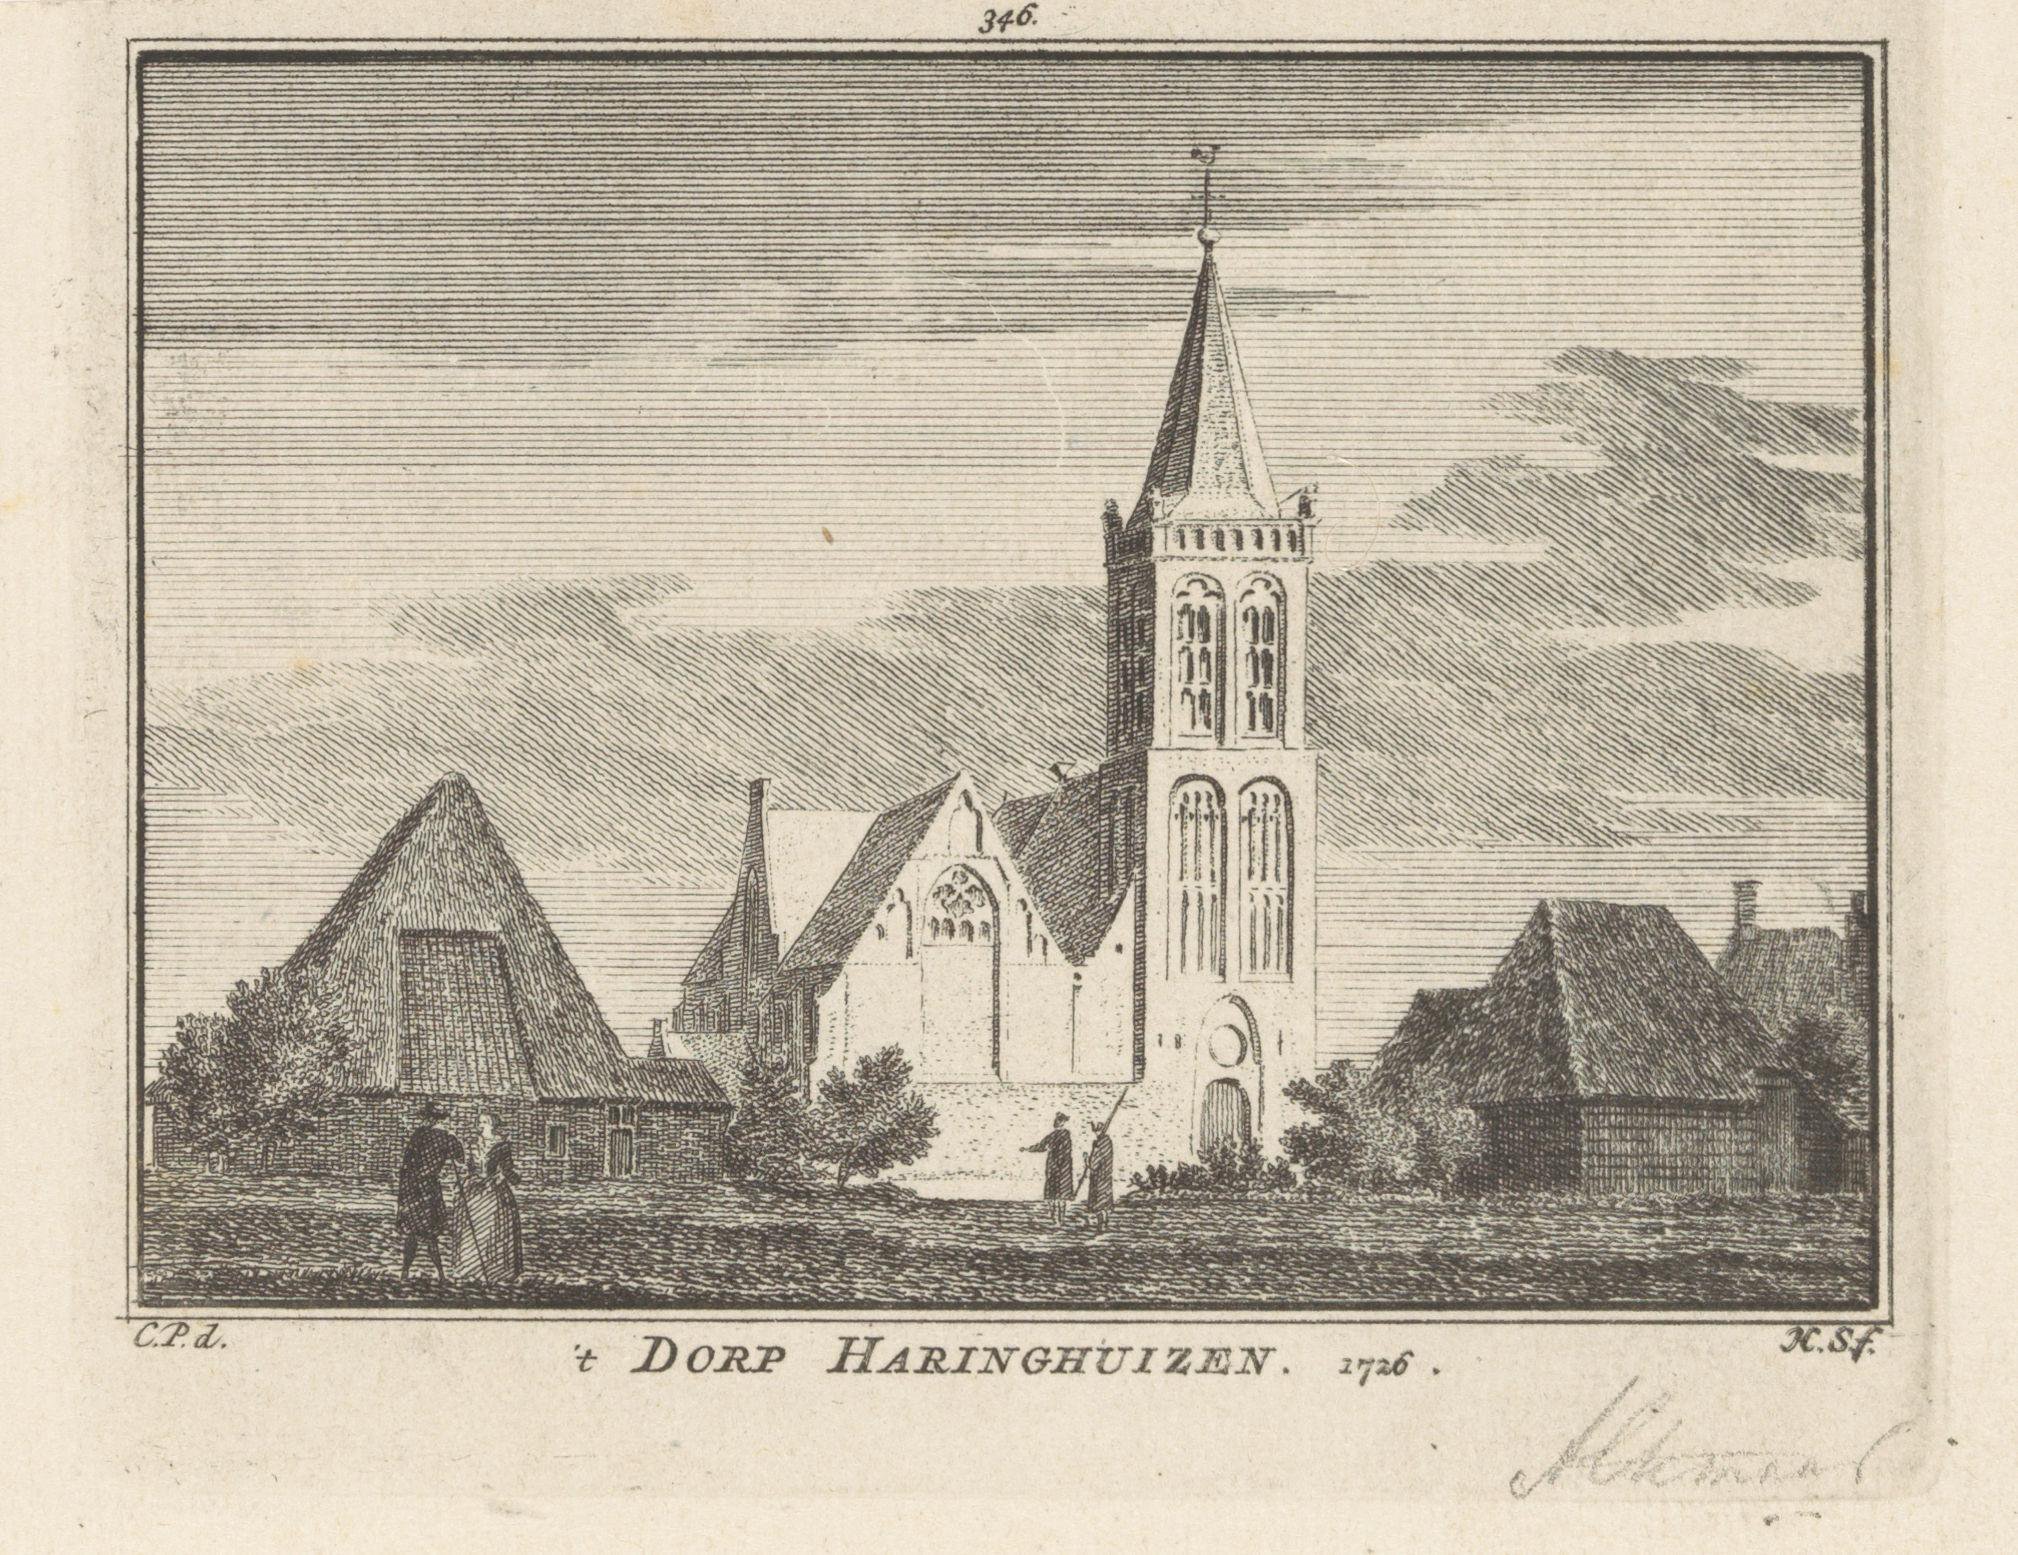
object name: book illustration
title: 't Dorp Haringhuizen. 1726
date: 1752-1792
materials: paper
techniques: engraving, etching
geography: haarlem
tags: prospect of village, silhouette of village, church (exterior)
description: Prent ook gebruikt in: Het verheerlykt Nederland of kabinet van hedendaagsche gezigten van steden, dorpen (…). 9 delen. Amsterdam: Isaak Tirion en weduwe Isaak Tirion, 1745-1774, dl. 4 (1752), ill. 346. Of in: Nederlandsche tafereelen; of eene keurige verzameling van negen honderd fraaije gezigten van steden, dorpen, sloten, oudheden (….). 9 delen. Amsterdam: Jan de Groot, 1792, dl. 4, ill. 346. Uit welke druk het huidige exemplaar precies komt is niet na te gaan.